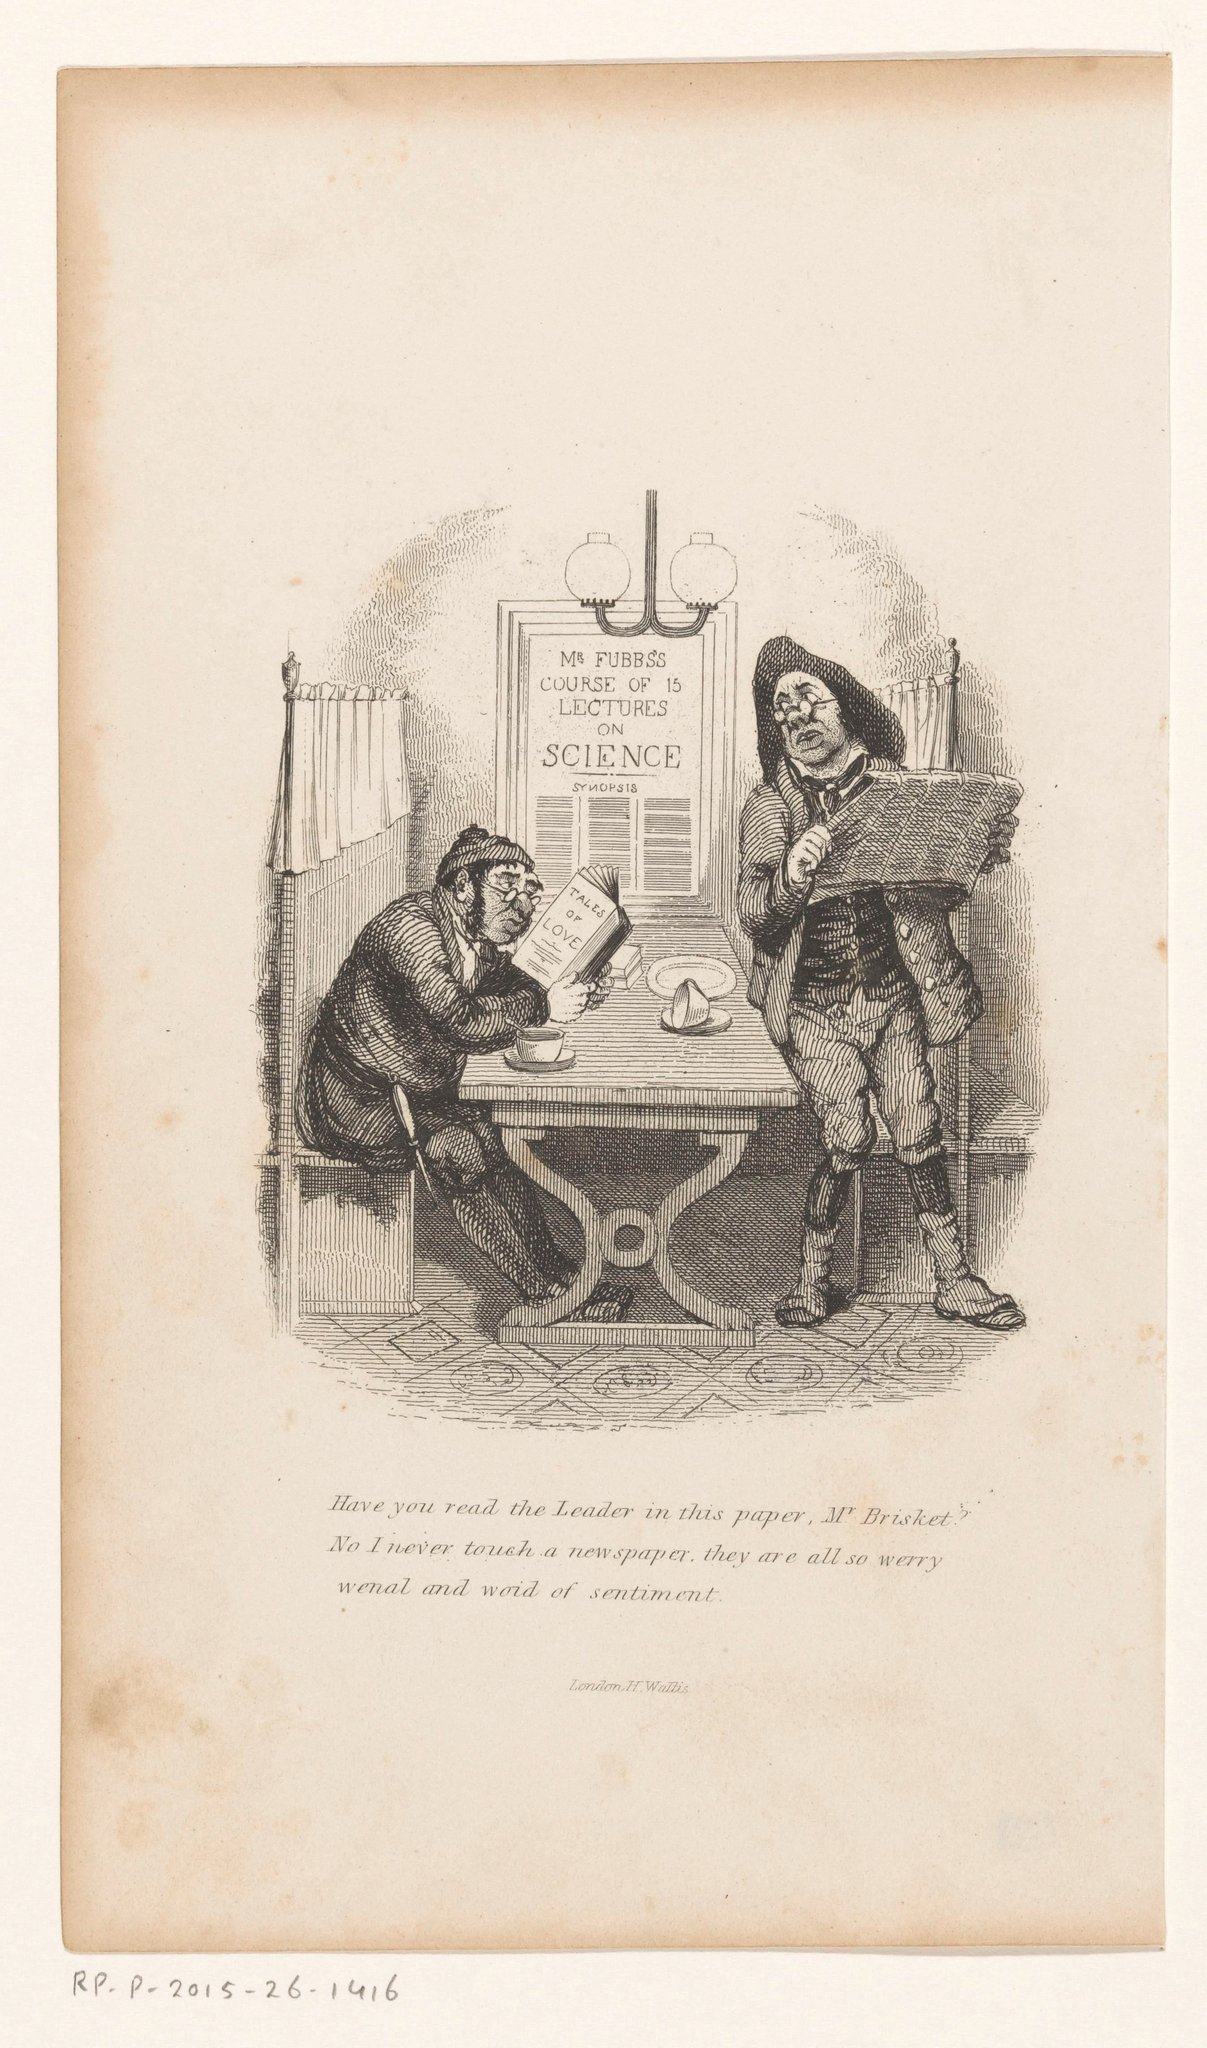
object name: print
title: Twee mannen in gesprek in een koffiehuis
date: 1834-1836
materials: paper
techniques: etching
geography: london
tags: reading, inn, coffee-house, public house, etc., book, newspaper, news-sheet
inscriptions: collector's mark: Lugt 4780, collector's mark: Lugt 2228, collector's mark: Lugt 4779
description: Deze prent maakt deel uit van de serie 'Sketches by Seymour', mogelijk bestaand uit 90 prenten. Deze serie werd voor het eerst uitgegeven door Richard Carlisle in vijf delen tussen 1834-1836. Waarschijnlijk is deze prent afkomstig uit een latere uitgave.